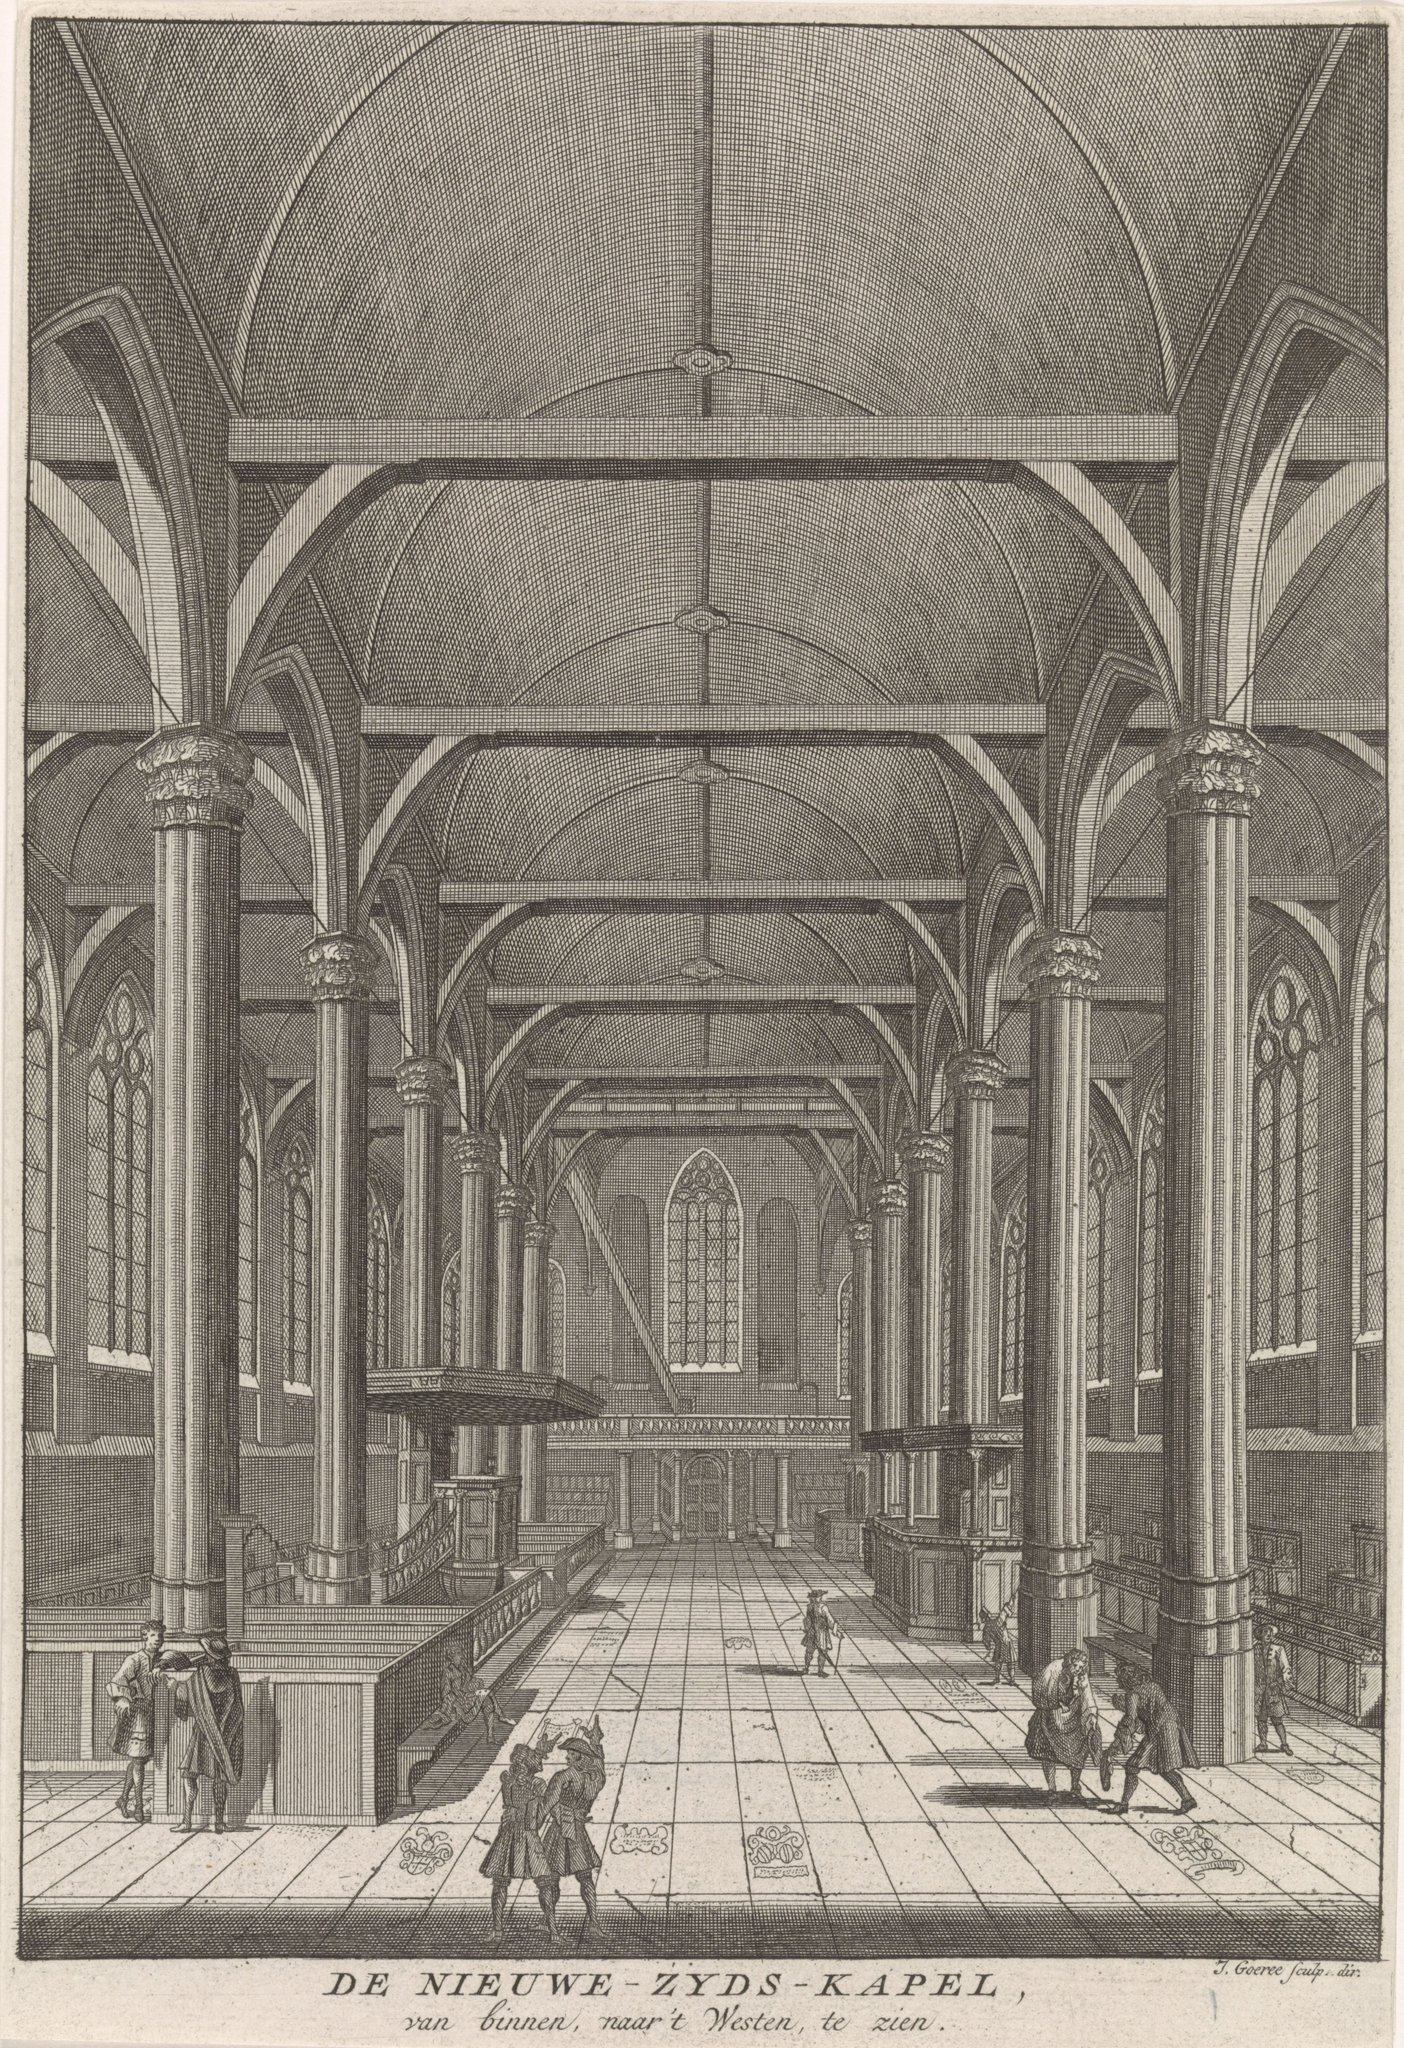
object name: print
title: Interieur van de Nieuwezijds Kapel te Amsterdam, gezien richting het westen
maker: jan goeree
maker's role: draughtsman, print maker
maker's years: 1670-1731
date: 1680-1731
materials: paper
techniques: engraving, etching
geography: amsterdam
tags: parts of church interior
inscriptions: collector's mark: Lugt 2228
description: Het interieur van de Nieuwezijds Kapel van Amsterdam met zicht op de uitgang, gezien naar het westen. Op de voorgrond enkele kerkgangers. De prent heeft een Nederlands onderschrift.